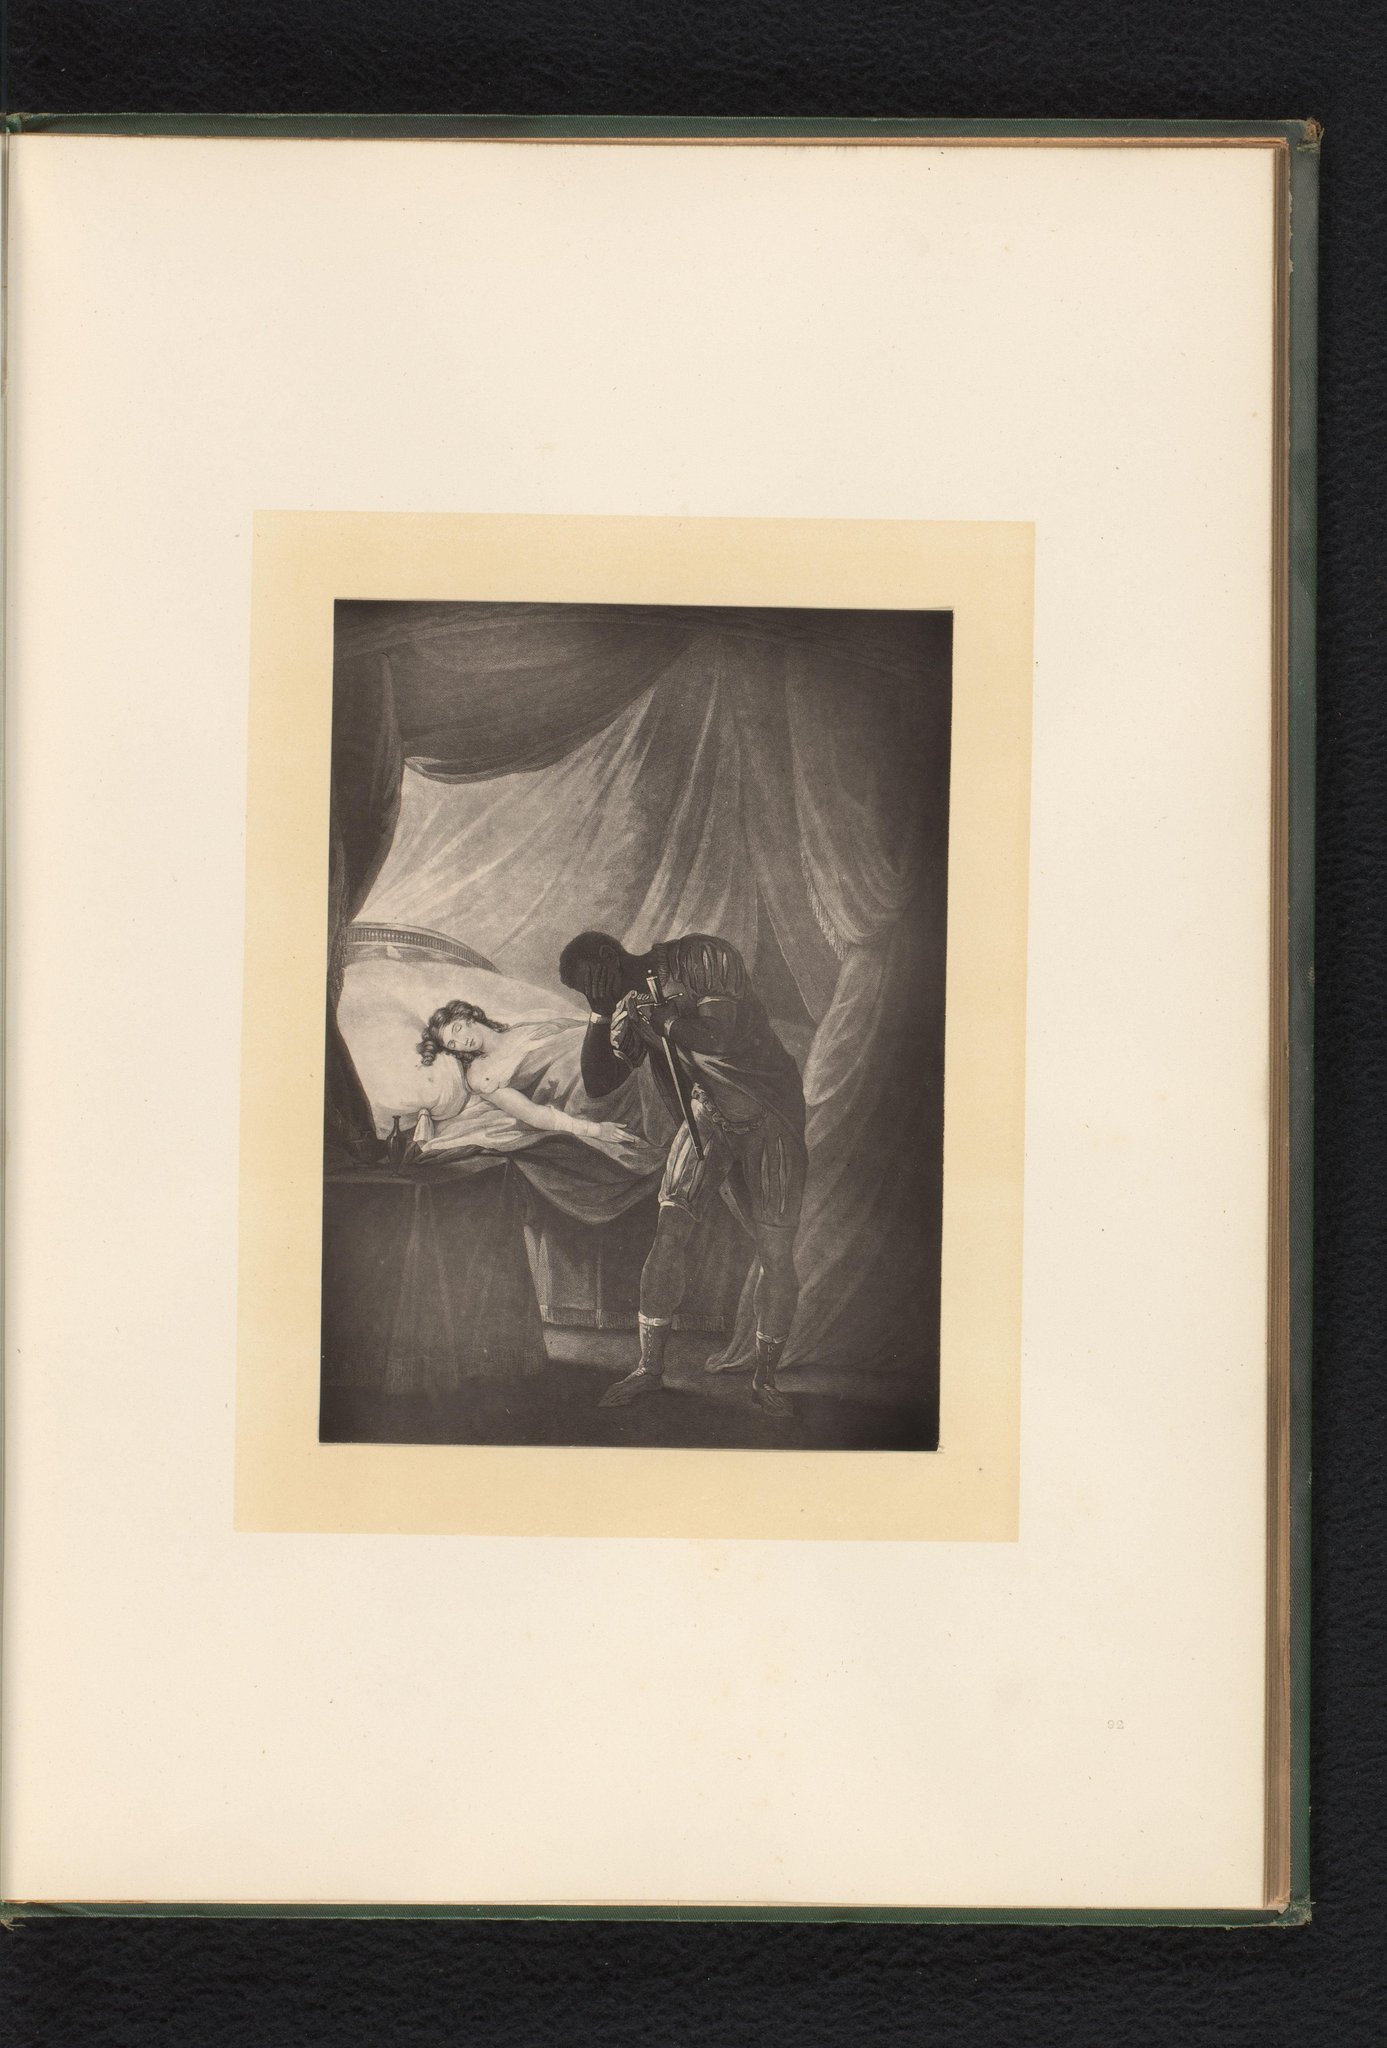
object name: photomechanical print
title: Othello, Act V, Scene 2: A Bedchamber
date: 1874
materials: paper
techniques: woodburytype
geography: london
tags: 82a(othello)3